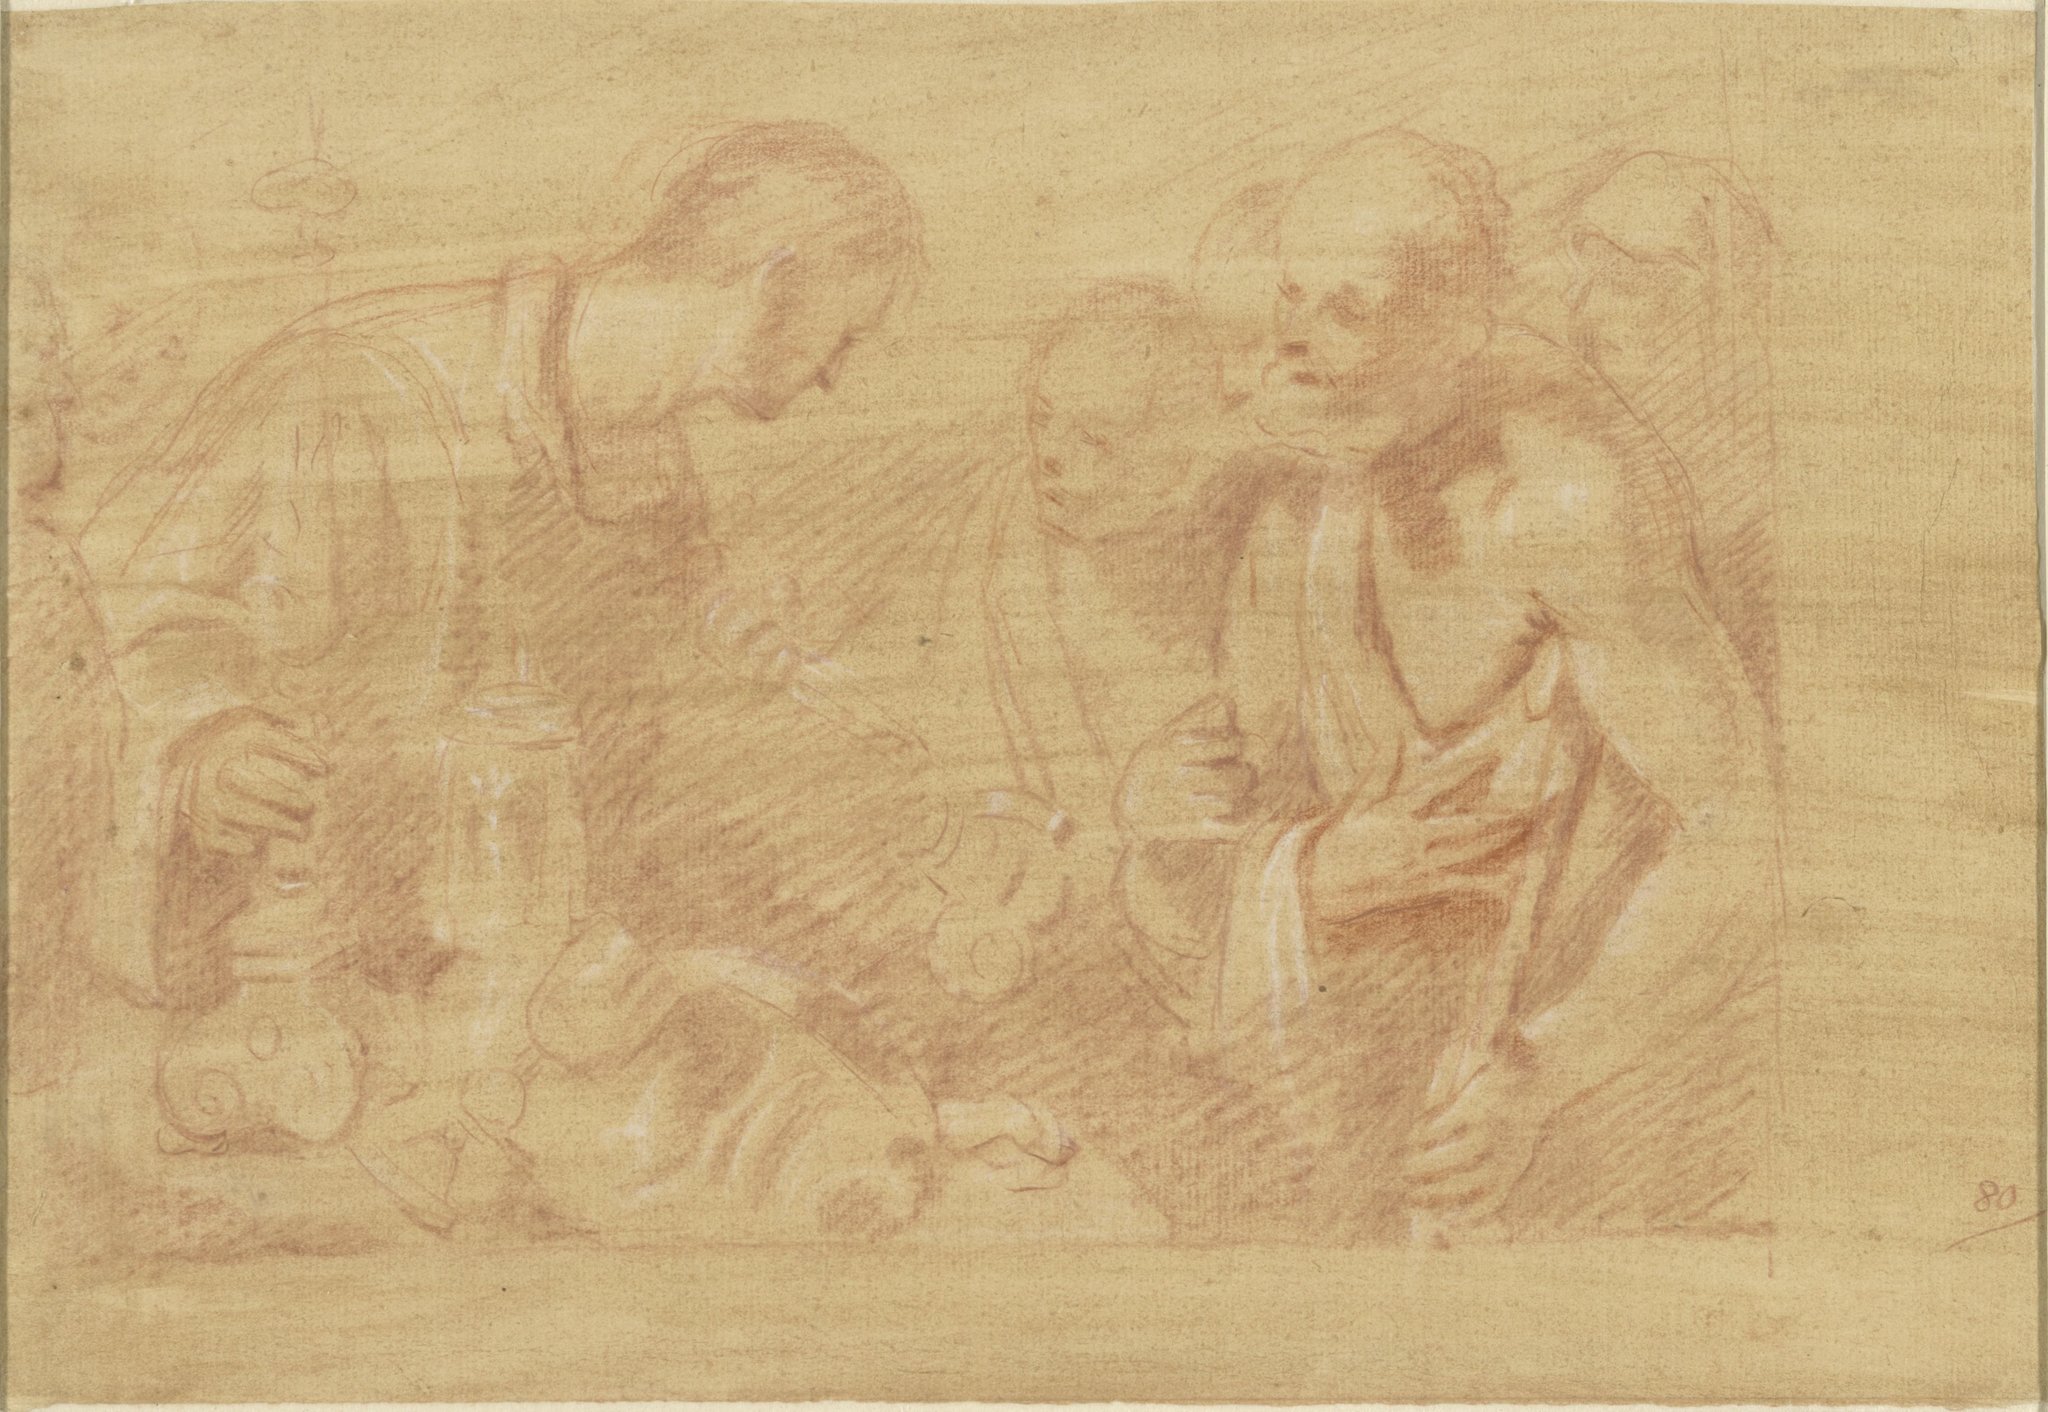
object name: drawing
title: H. Laurentius en de armen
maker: bernardo strozzi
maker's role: draughtsman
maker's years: 1581-1644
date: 1600-1699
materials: chalk, paper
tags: the charity of st. laurence: he distributes the treasures of the church (gold and silver dishes and cups, vessels) to the poor; he holds a bag of money